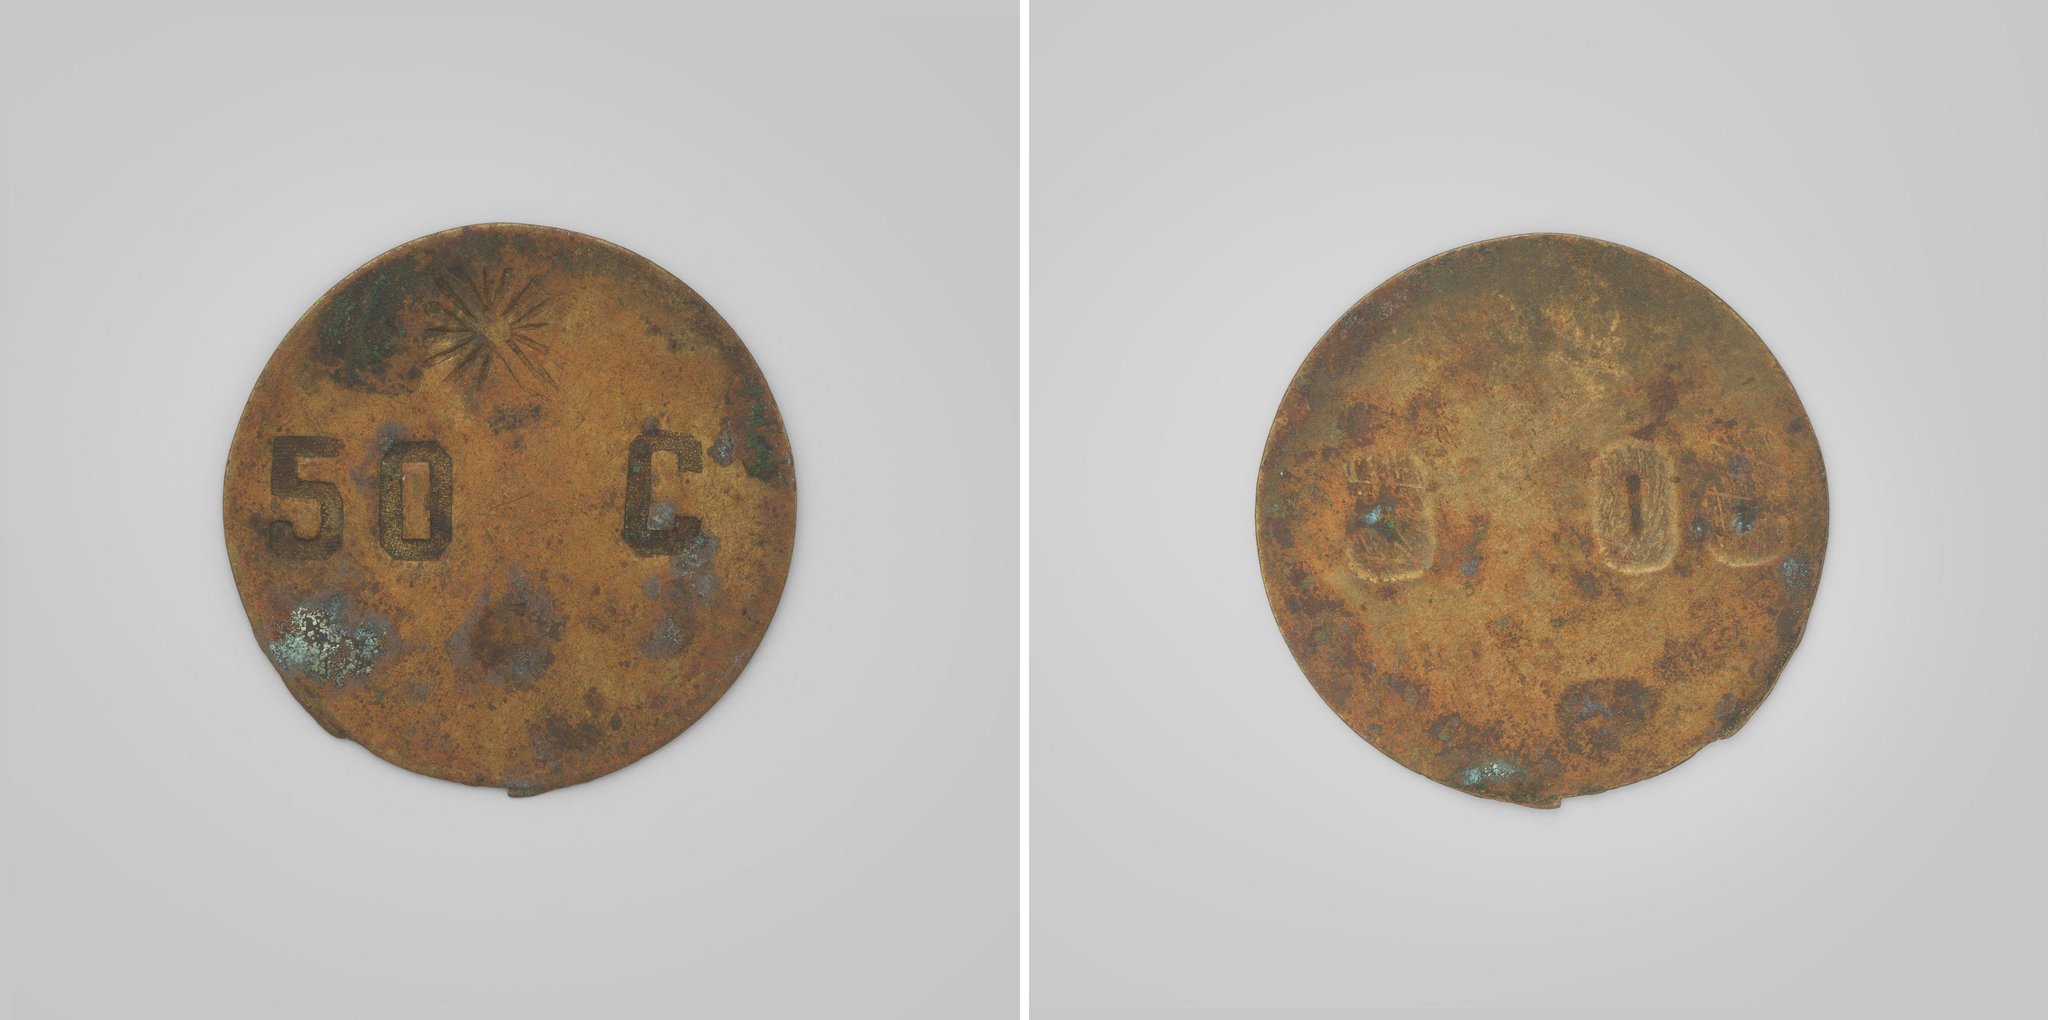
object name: history medal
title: Betaalpenning van 50 cents van de Coöperatieve Winkelvereeniging Eendracht Maakt Magt te Hilversum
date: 1875-1900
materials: brass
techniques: printing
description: Rond messing plaatje met inwaartse instempelingen (ster) / 50 C